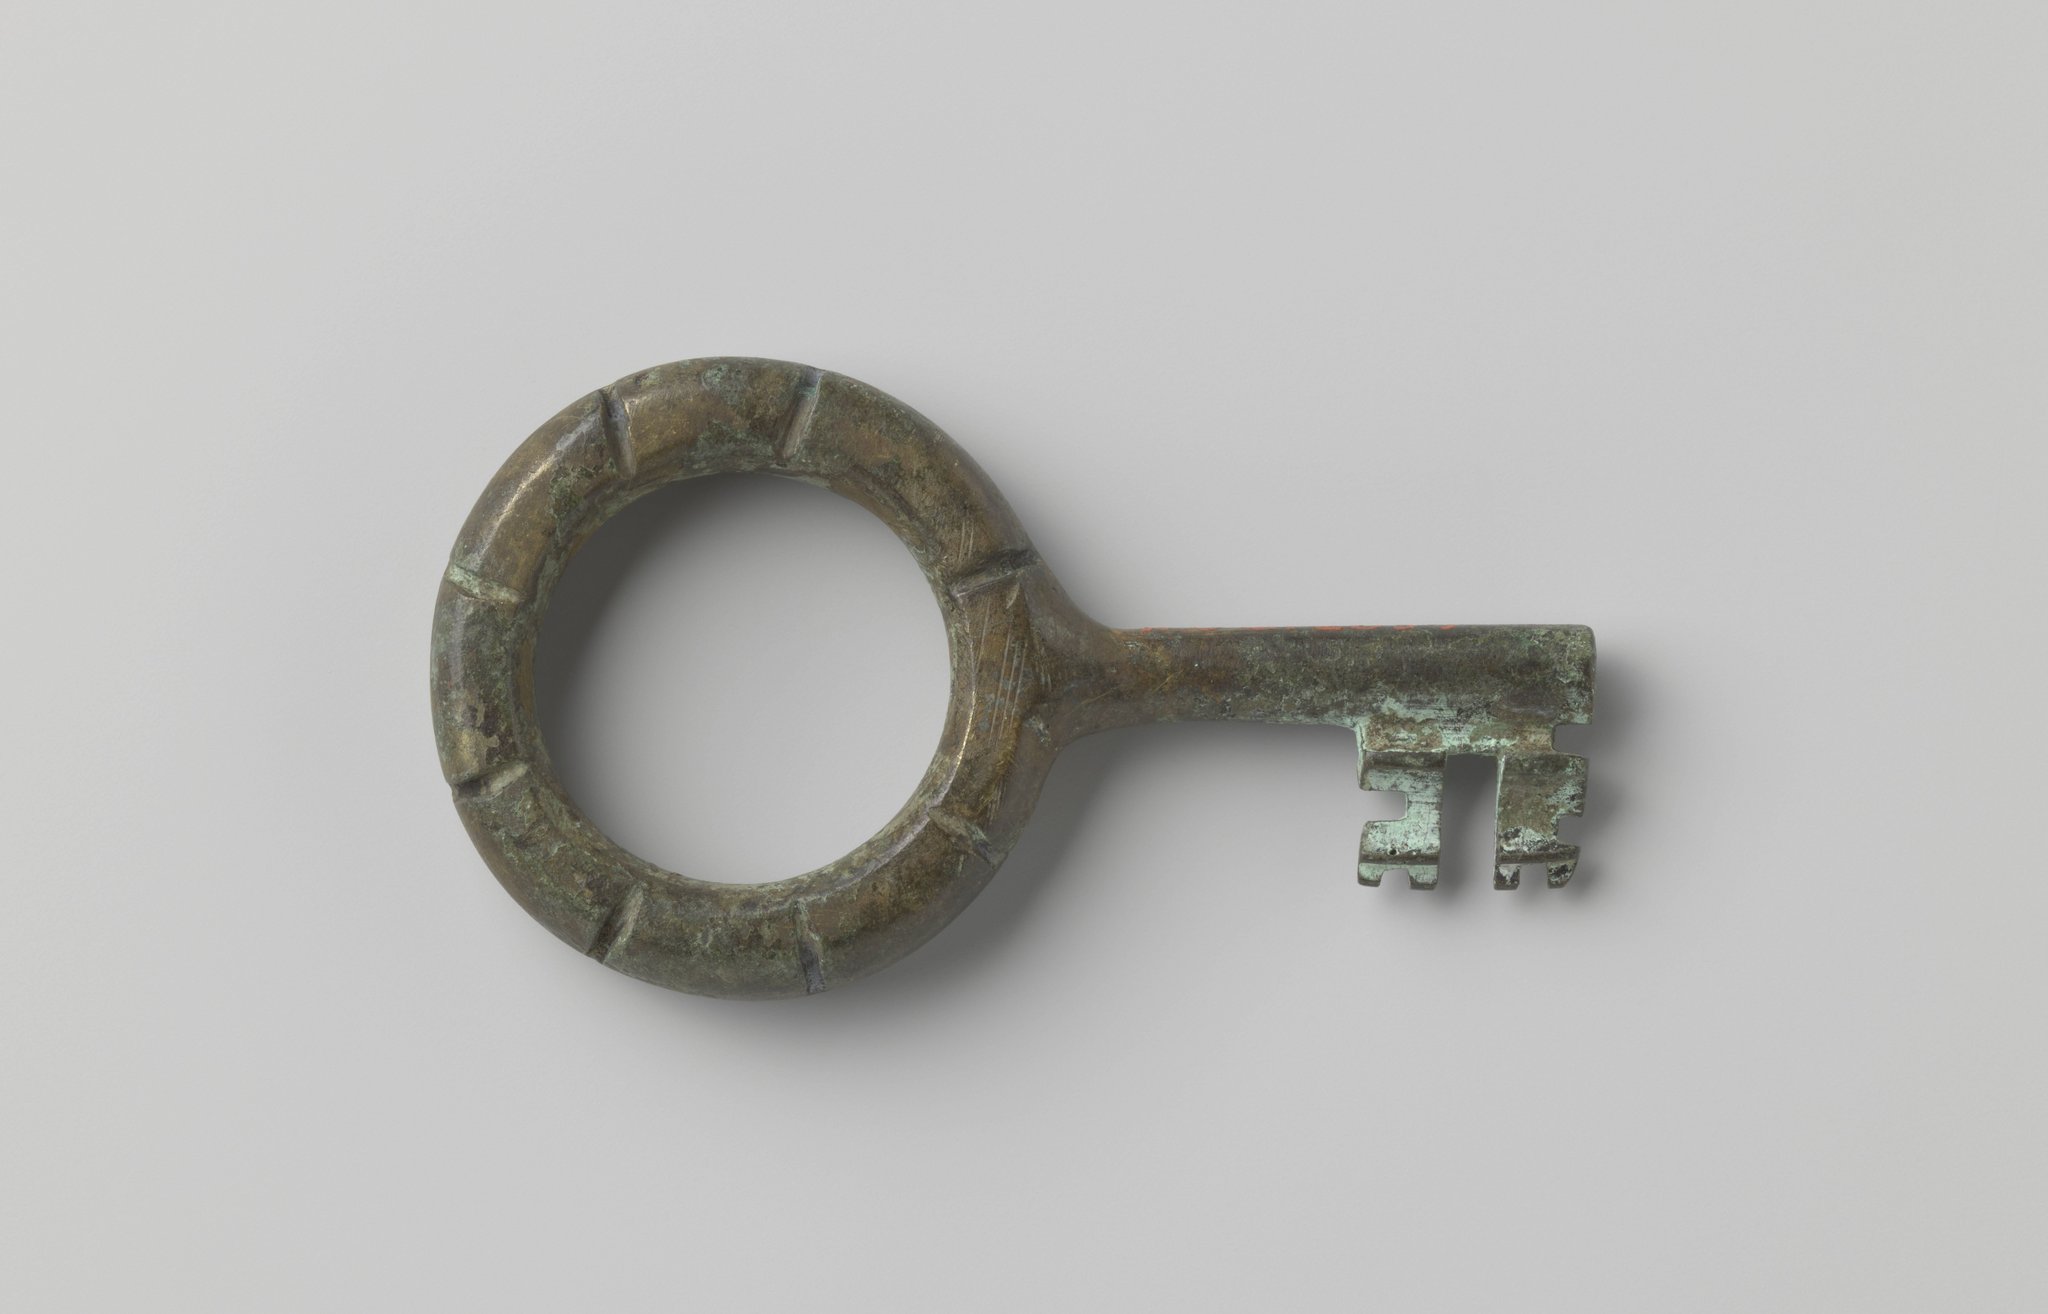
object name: key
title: Sleutel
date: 1700-1800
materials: bronze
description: Sleutel met groot, ringvormig oog door dwarse inkepingen van een zijde versierd.